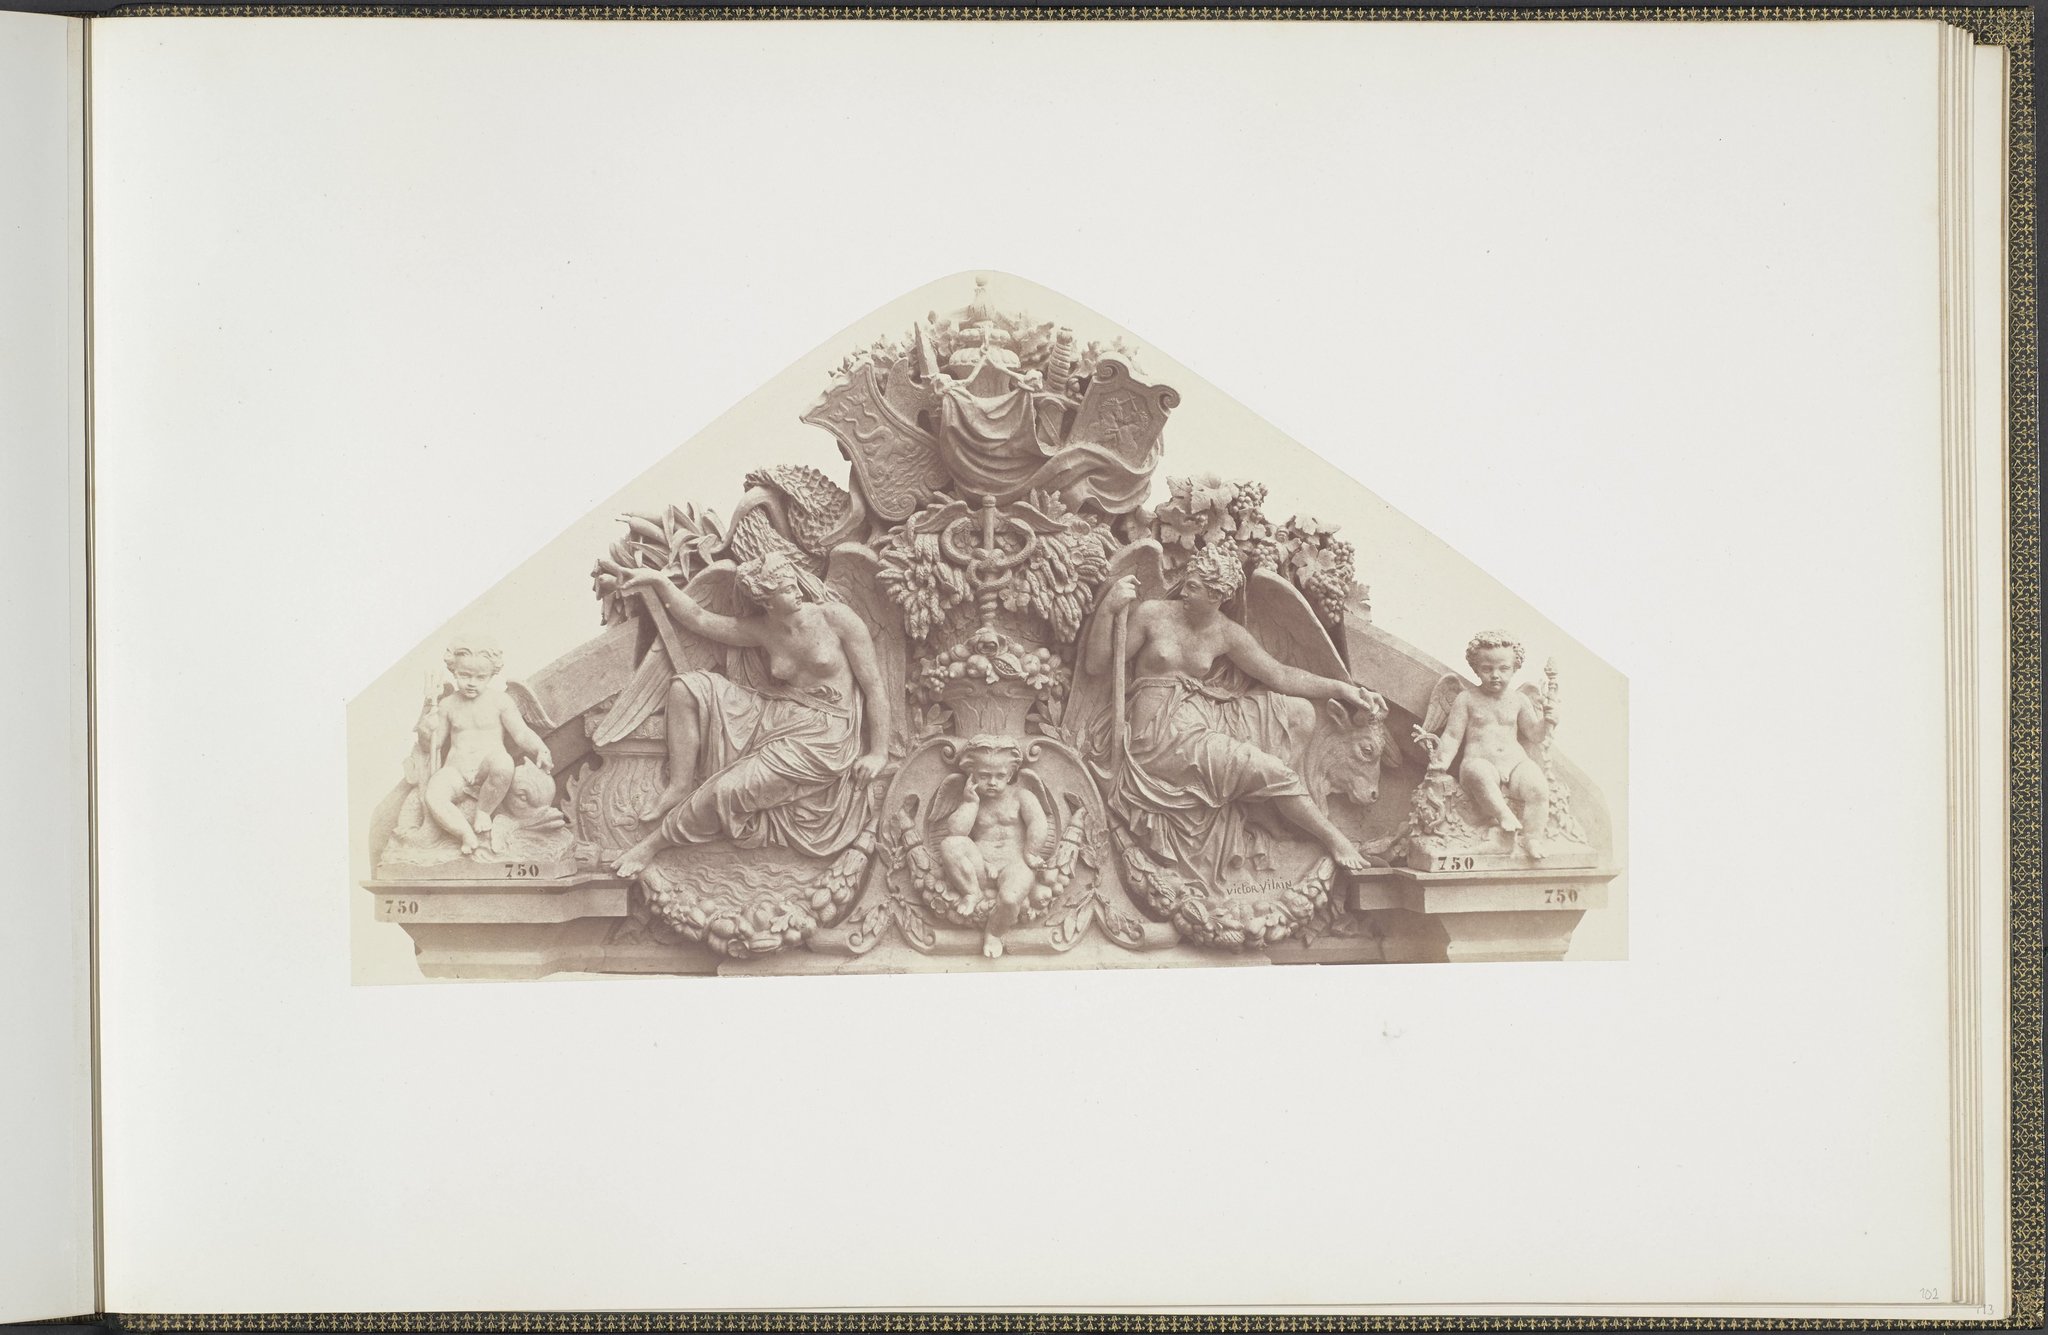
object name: album leaf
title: Gipsmodel voor beeldhouwwerk op het Palais du Louvre: "La Terre et l'Eau" door Victor Vilain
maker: édouard denis baldus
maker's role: fotograaf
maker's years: 1813-1889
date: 1855-1857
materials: paper, photographic support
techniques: salted paper print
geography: paris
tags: piece of sculpture, reproduction of a piece of sculpture, permanent exhibition, museum, paris, tuileries palace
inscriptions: number: ‘750’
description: Onderdeel van Réunion des Tuileries au Louvre 1852-1857, album 1.